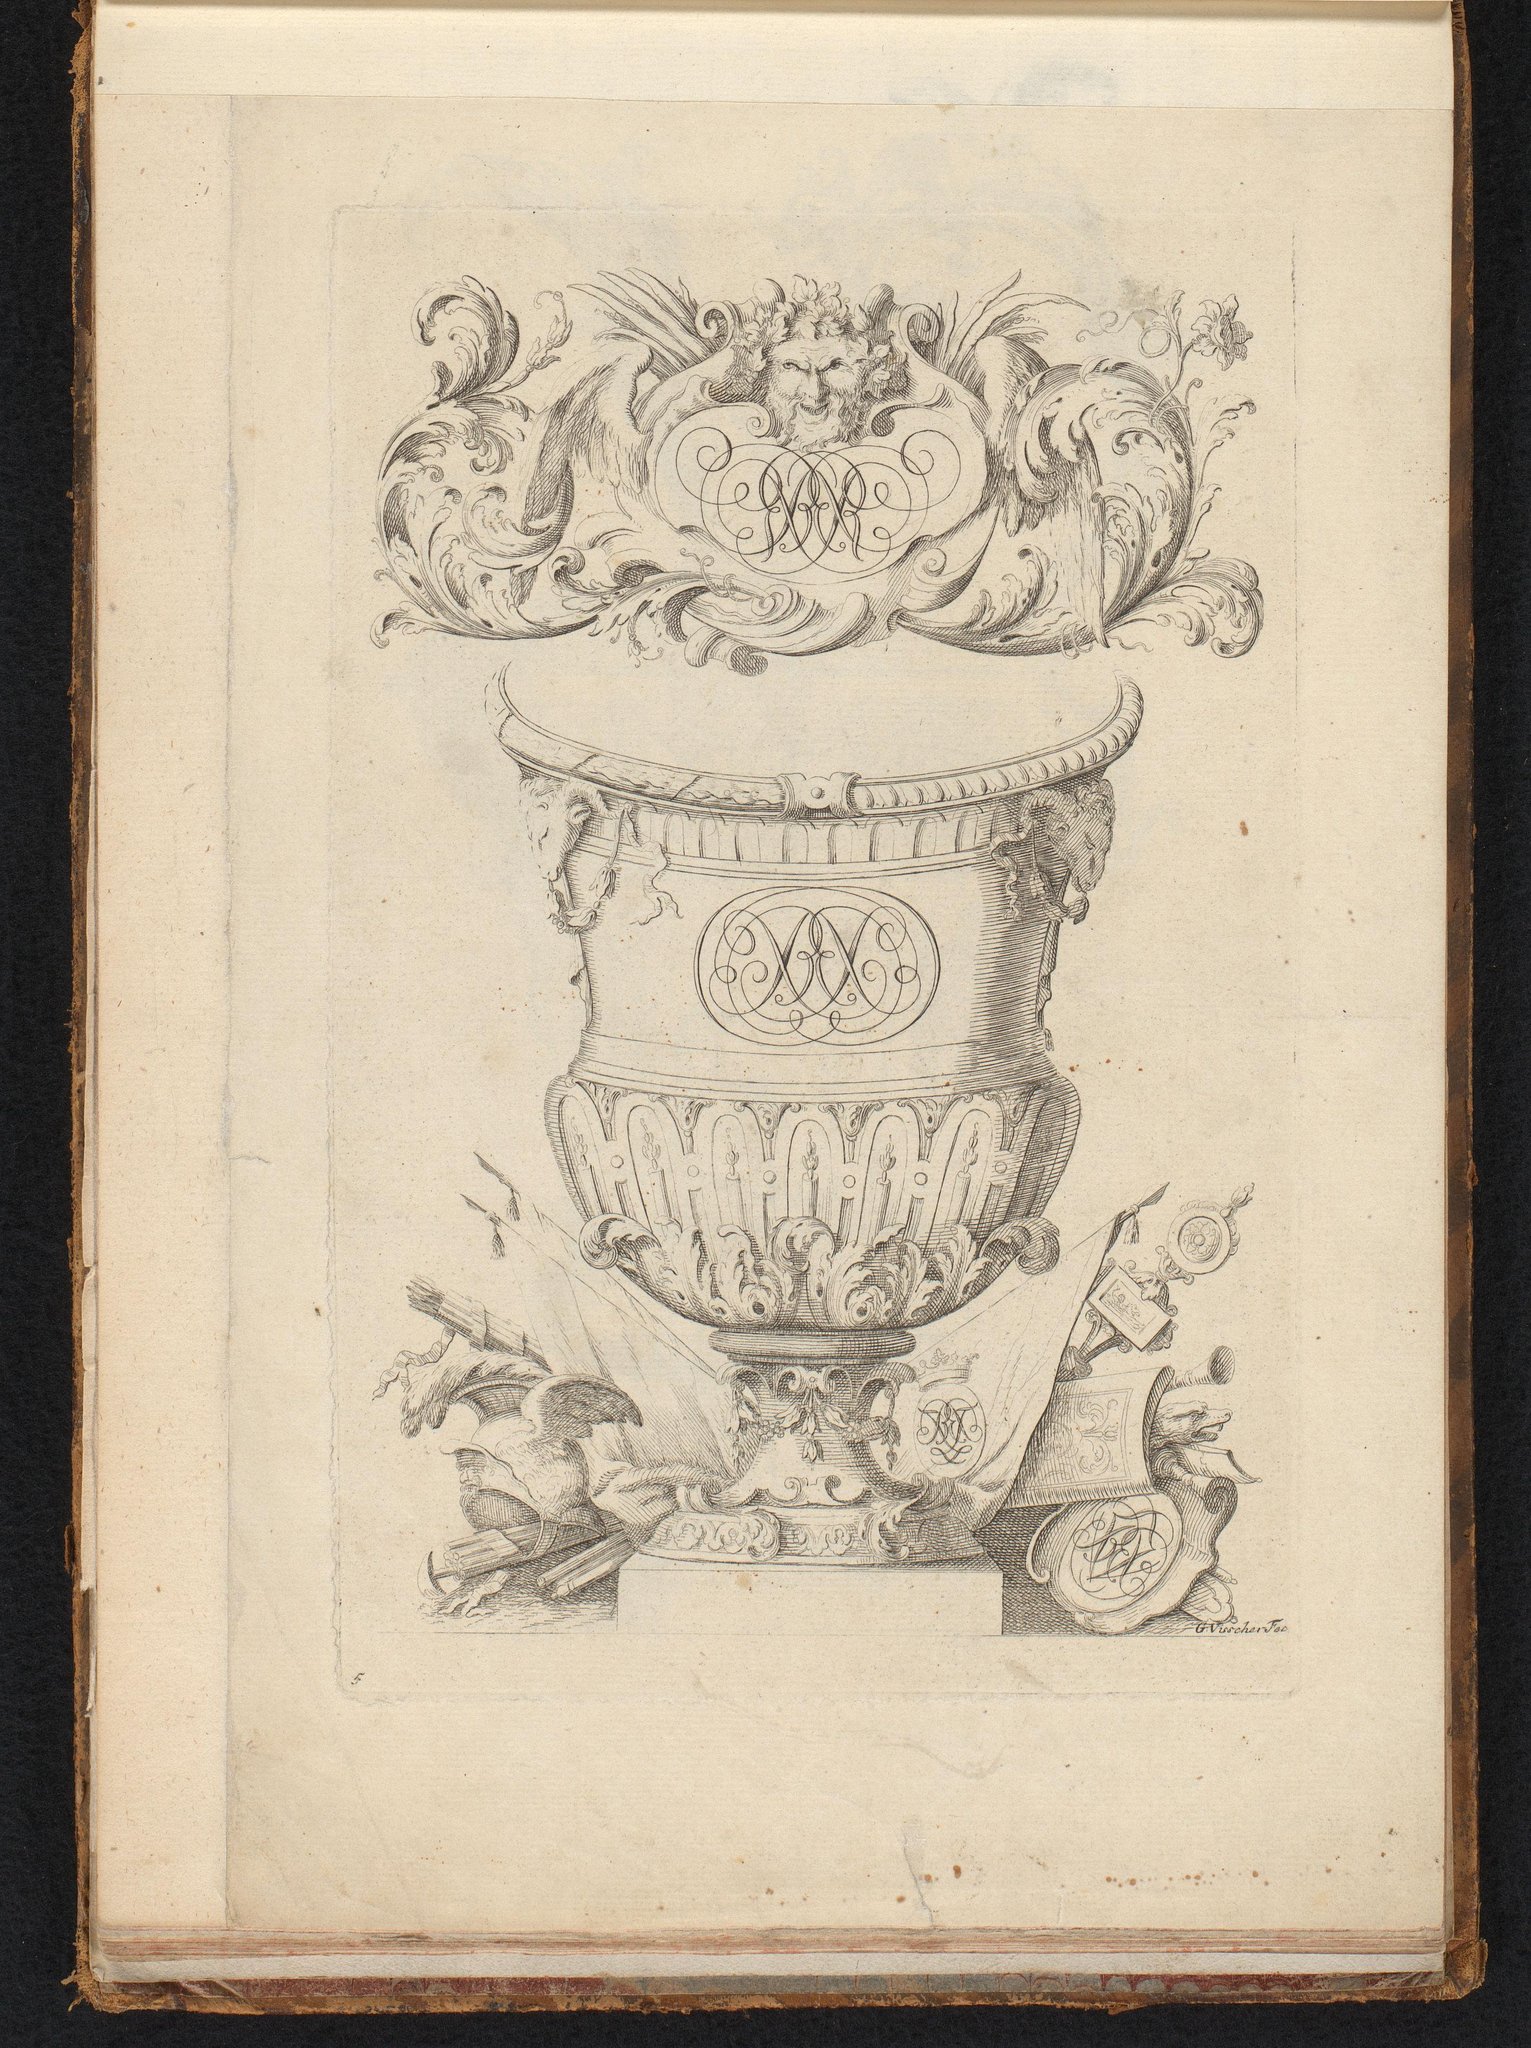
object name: print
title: Tuinvaas met twee monogrammen bekroond met saterkop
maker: gerrit visscher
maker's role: print maker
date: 1690-1710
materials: paper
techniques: engraving, etching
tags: vase ~ ornament, garden vase, letter combinations such as letterword, anagram, letter square, monogram, etc.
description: Linksonder genummerd: 5. Prent maakt deel uit van een album.